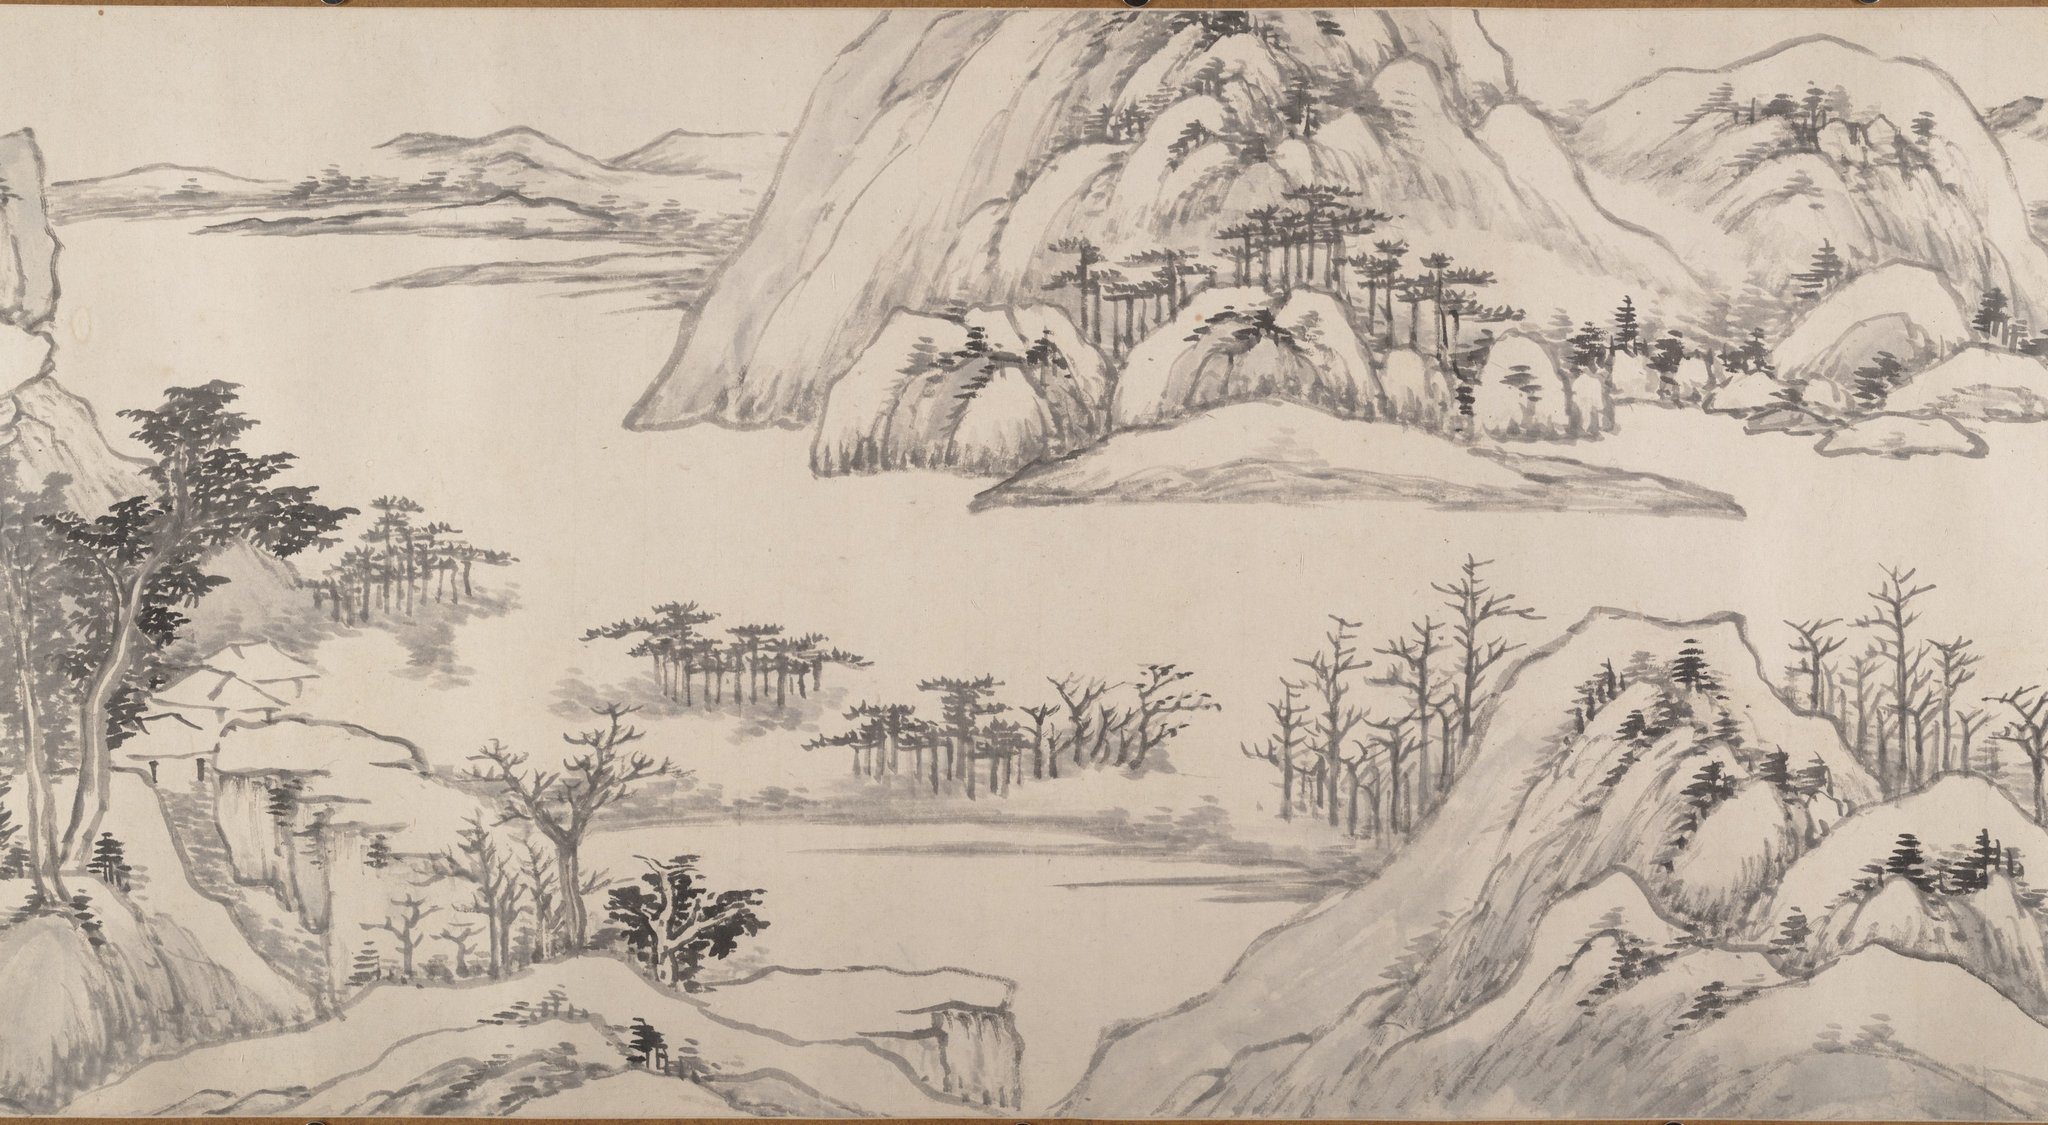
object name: handscroll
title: River Landscape in Autumn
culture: chinese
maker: luo mu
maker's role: artist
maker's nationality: chinese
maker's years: 1622-1706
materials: ink, paper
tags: rivers,mountains,landscapes